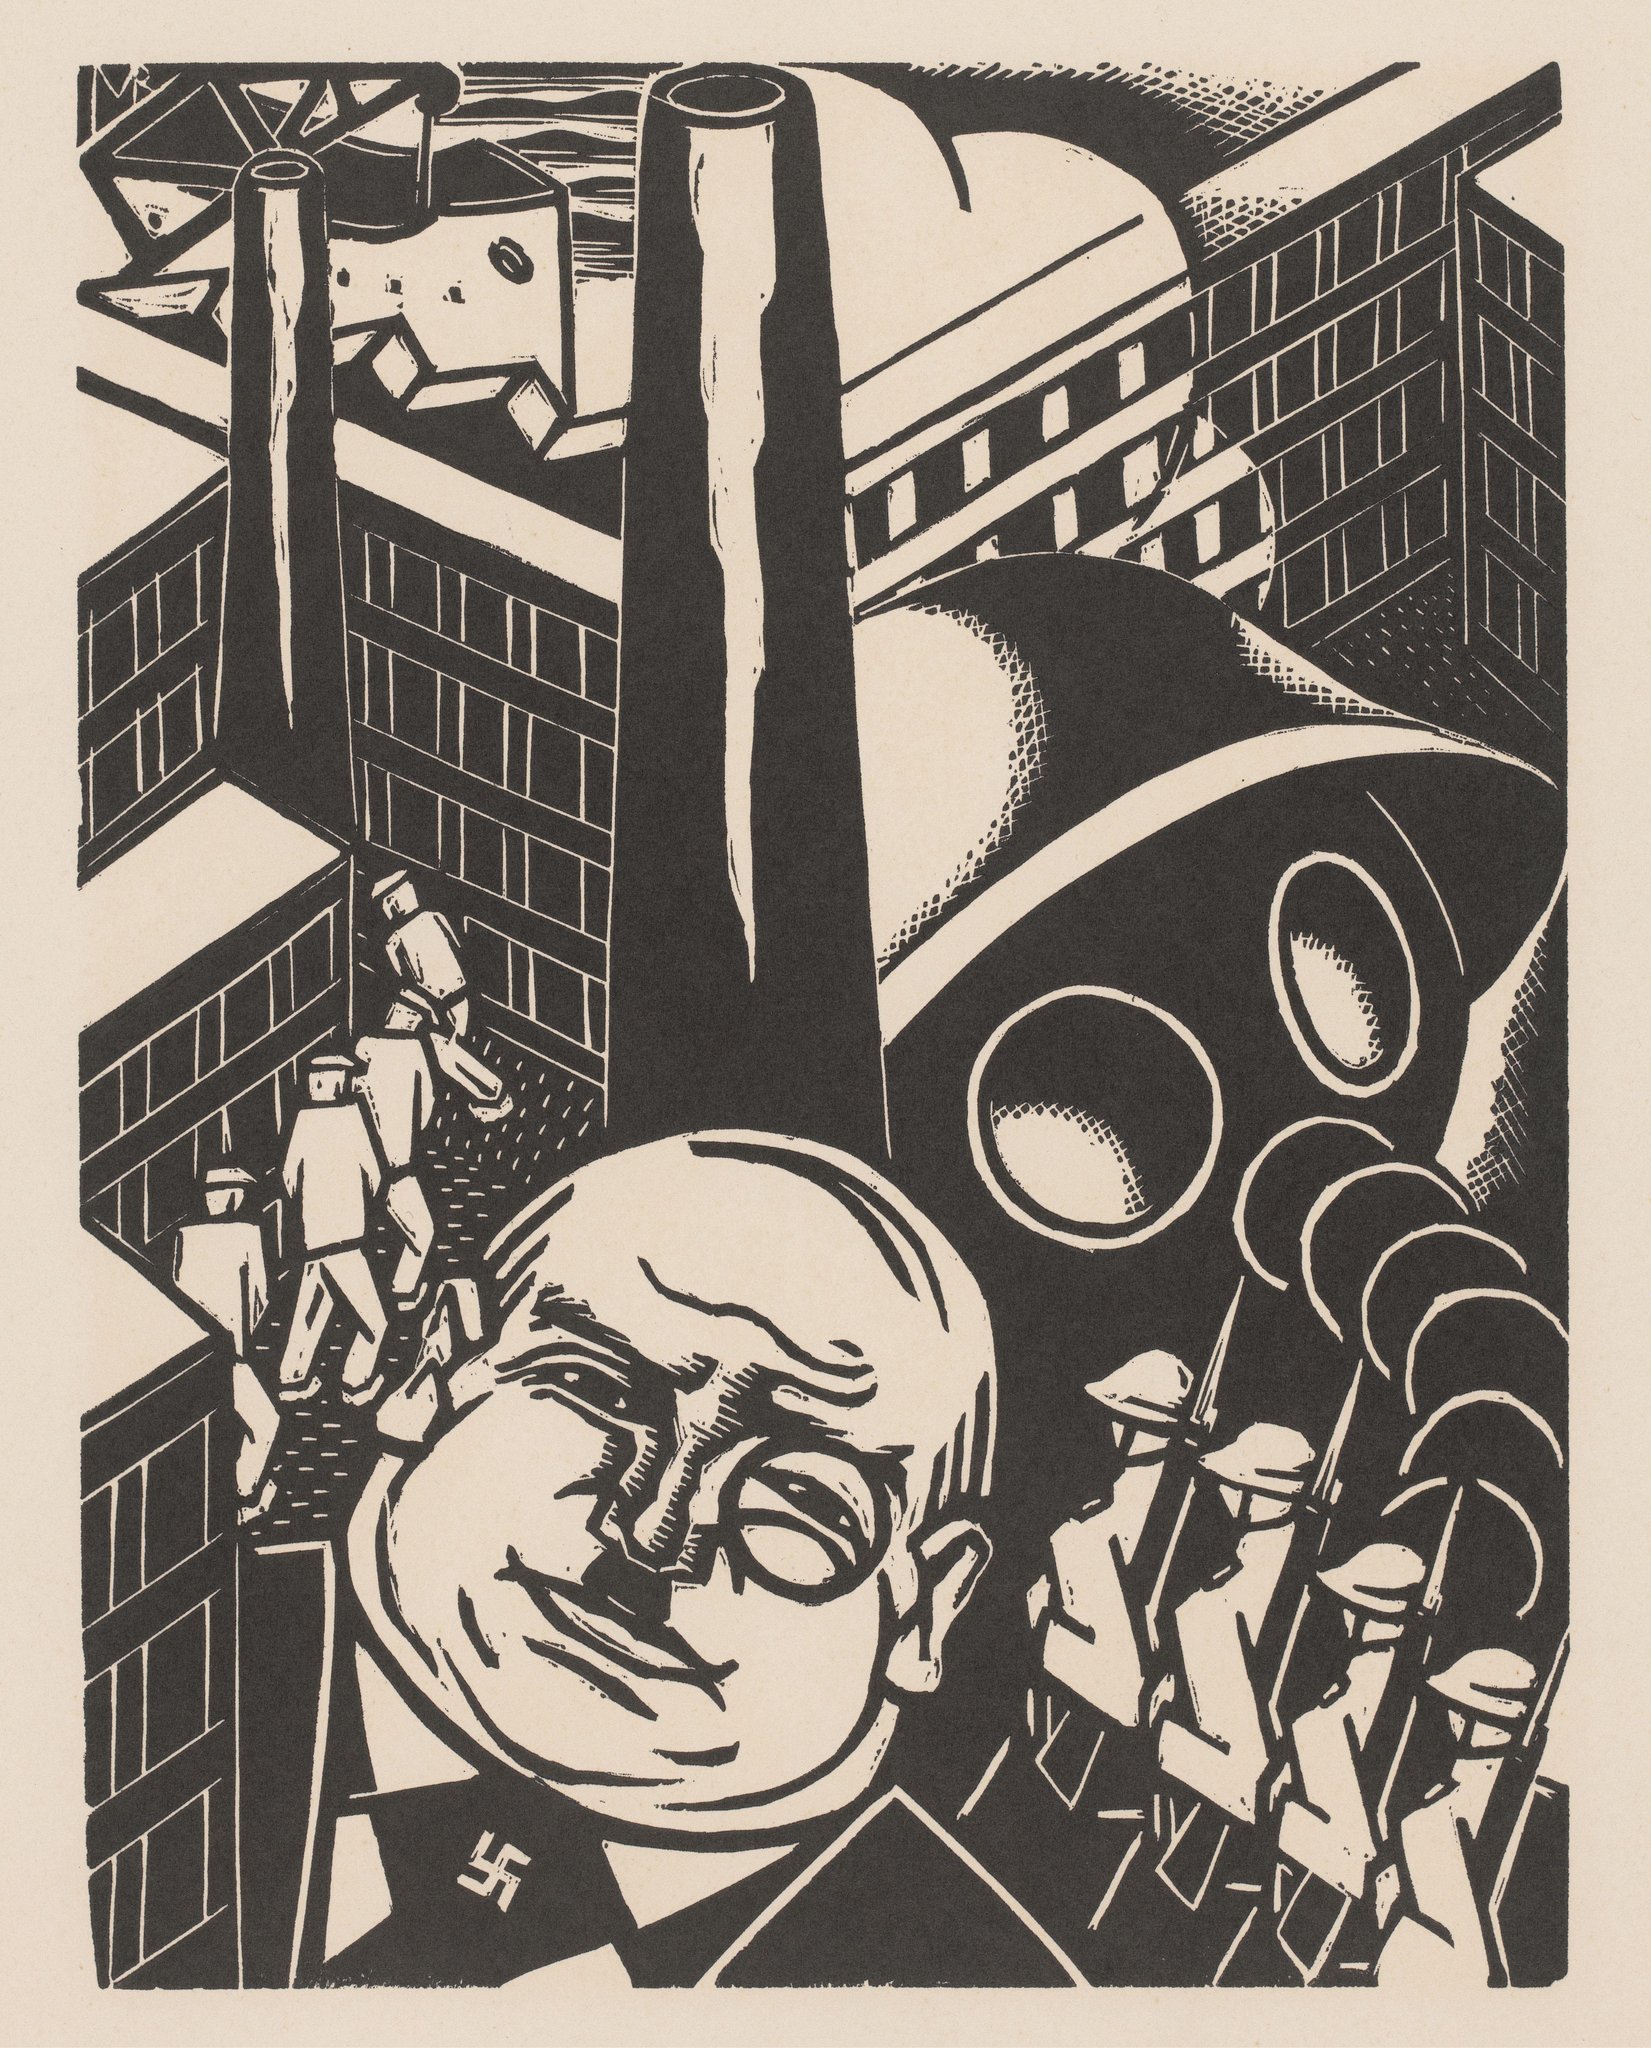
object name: print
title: Tegen oorlog en fascisme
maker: meijer bleekrode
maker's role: draughtsman, painter, print maker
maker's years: 1896-1943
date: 1933-1935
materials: paper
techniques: woodcut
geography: netherlands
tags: director, boss (in modern industry), anti-militarism, pacifism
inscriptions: signature: ‘MB’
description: Oorlogsindustrie onder het nationaal-socialisme. Op de voorgrond een fabrieksdirecteur met das met hakenkruis tegen een achtergrond van een fabriek met arbeiders, soldaten en een gasmasker. Politieke prenten van ca. 1933-1935. Onderdeel van een serie van zes houtsneden uitgegeven in een groene kartonnen omslag onder de titel: Tegen oorlog en fascisme.